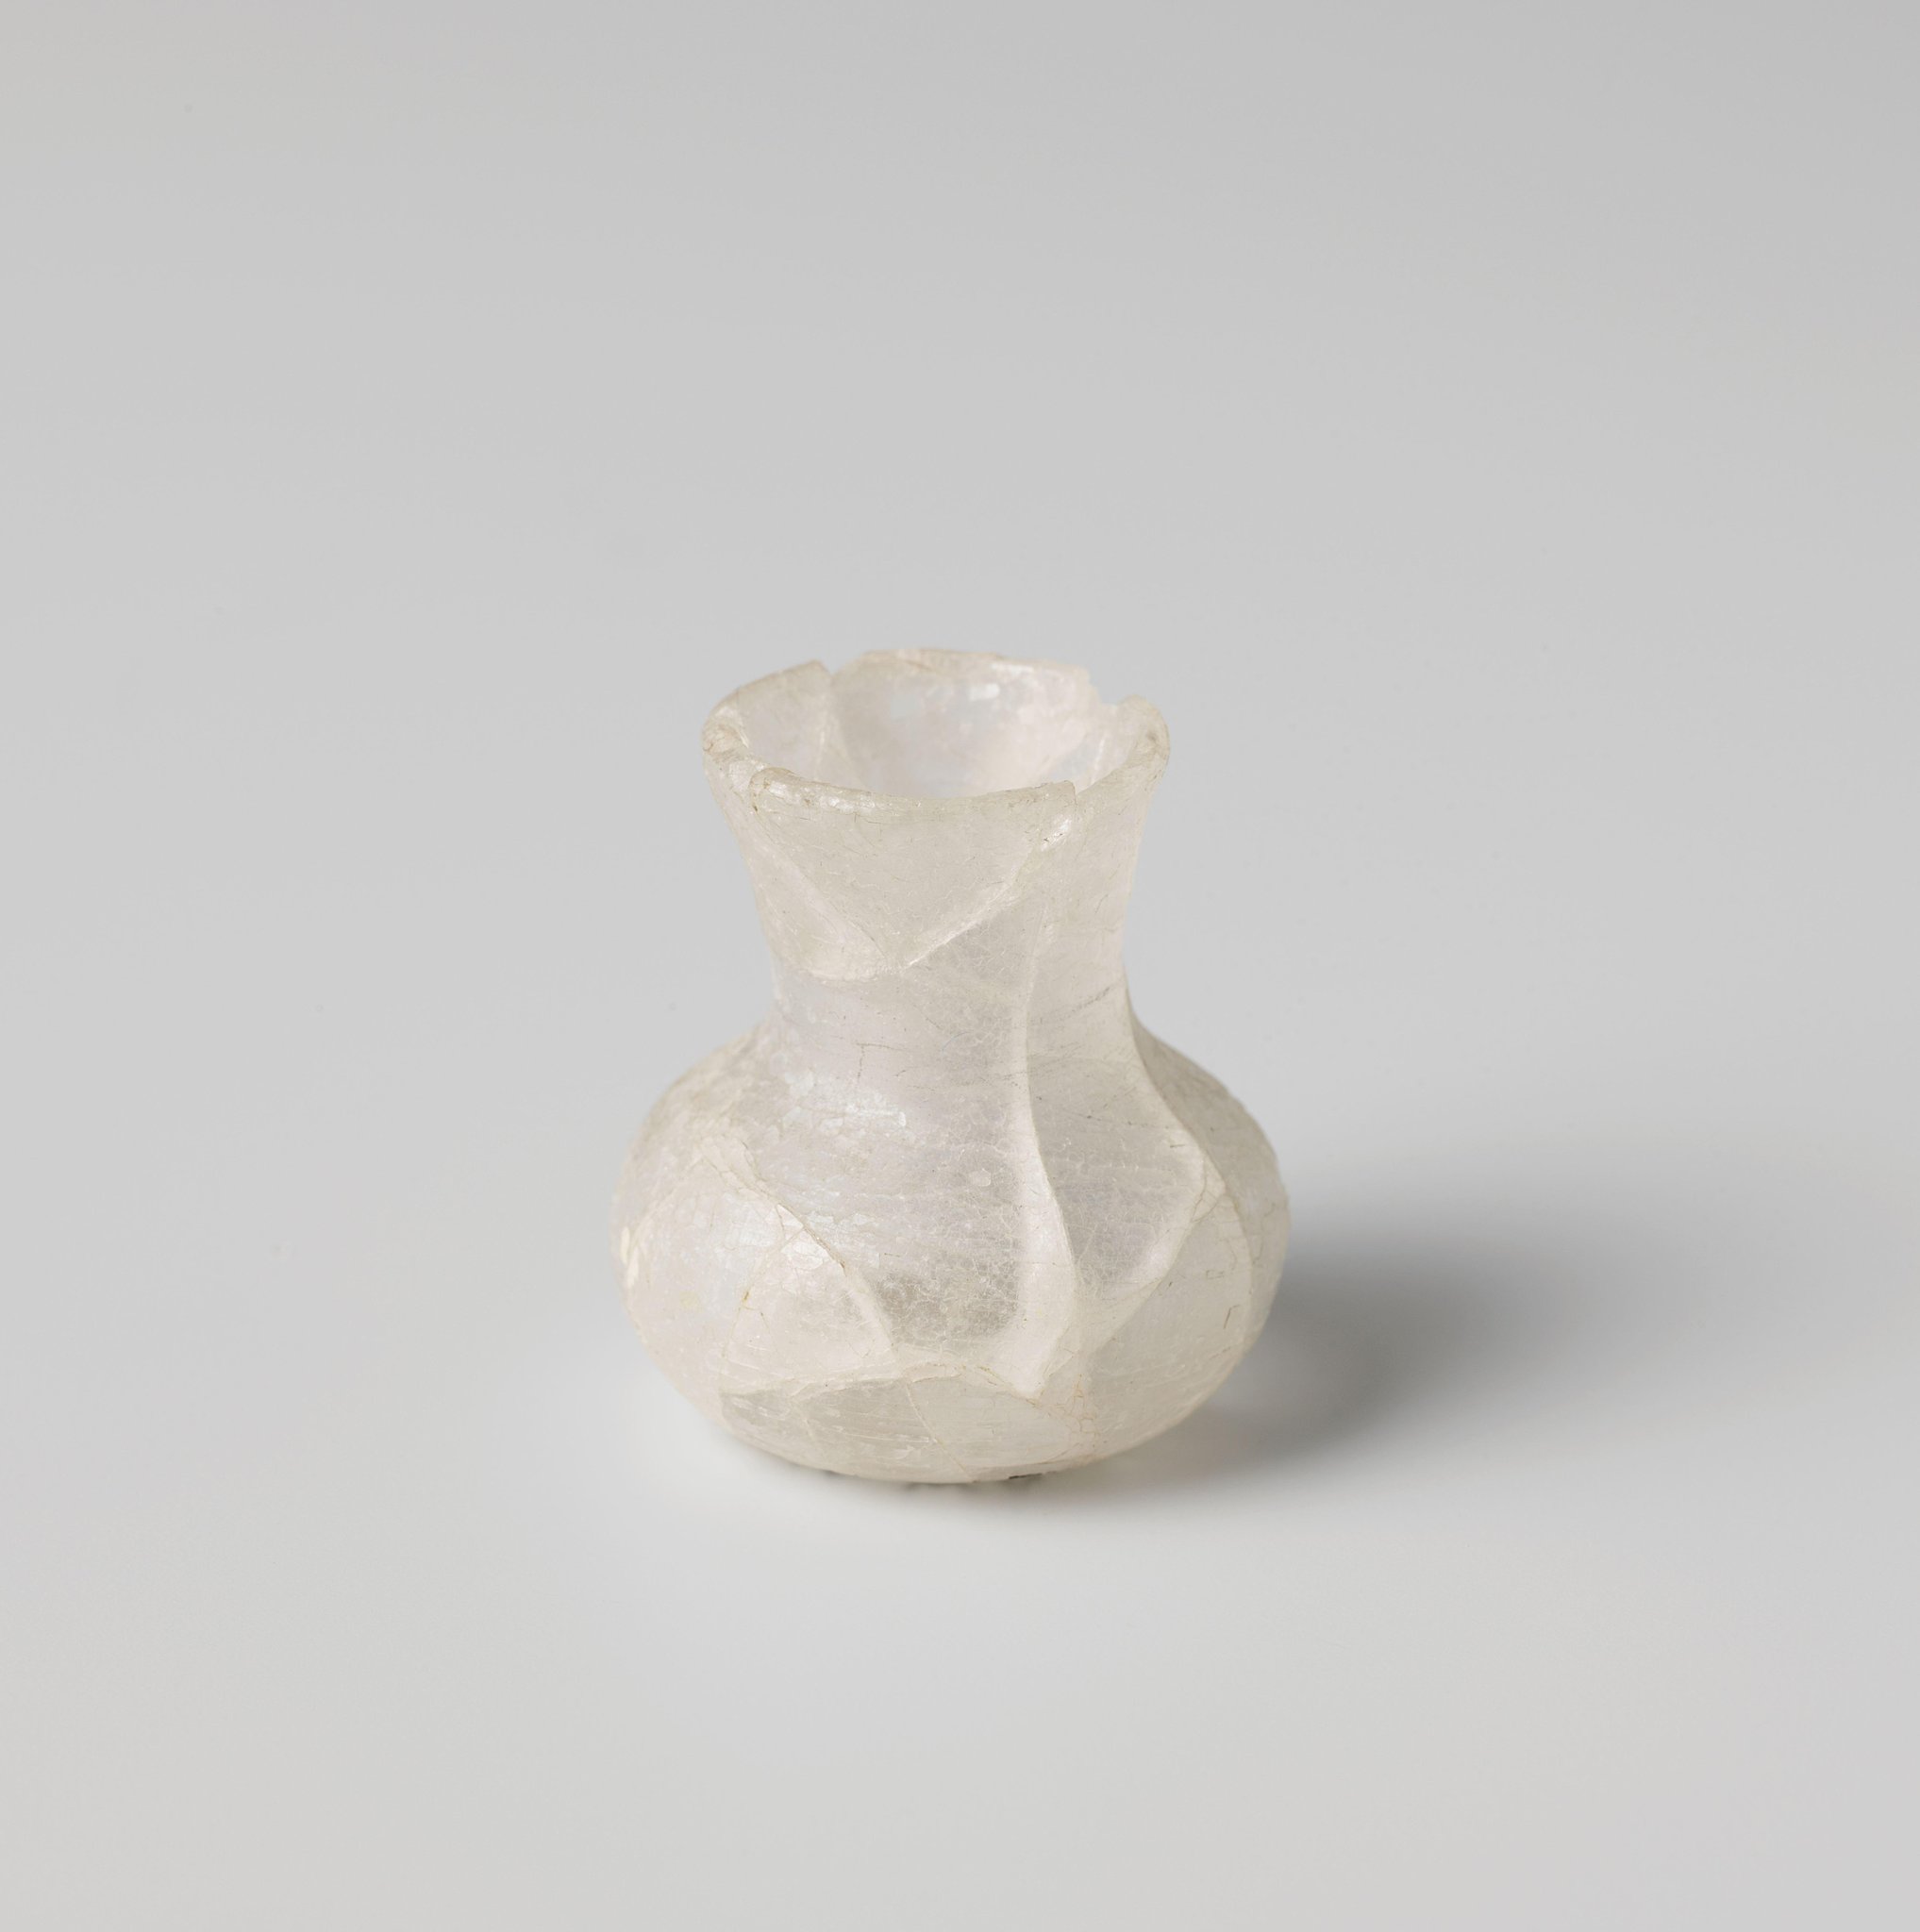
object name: miniature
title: Vaas van kleurloos glas, met bolle buik en iets uitlopende hals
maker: Anonymous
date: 1700-1799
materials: glass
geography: netherlands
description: Vaas oorspronkelijk van helder, kleurloos glas, nu door glasziekte ernstig aangetast. Bolle buik met brede hals boven iets uitlopend, iets holle bodem.